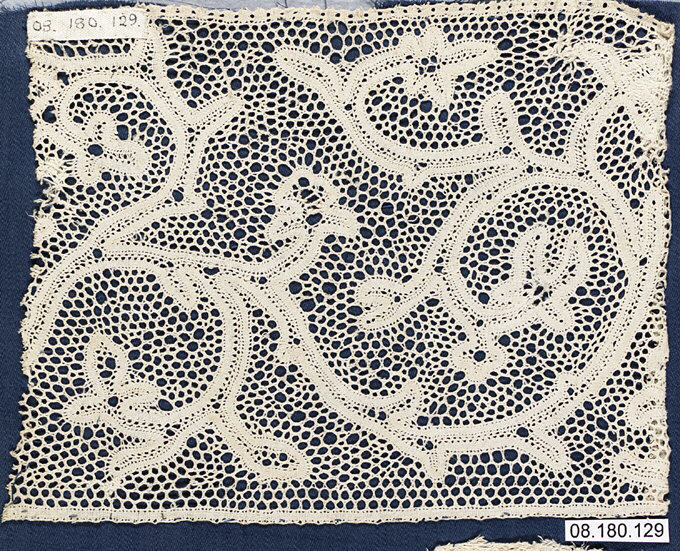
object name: fragment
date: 1601-1800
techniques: lace